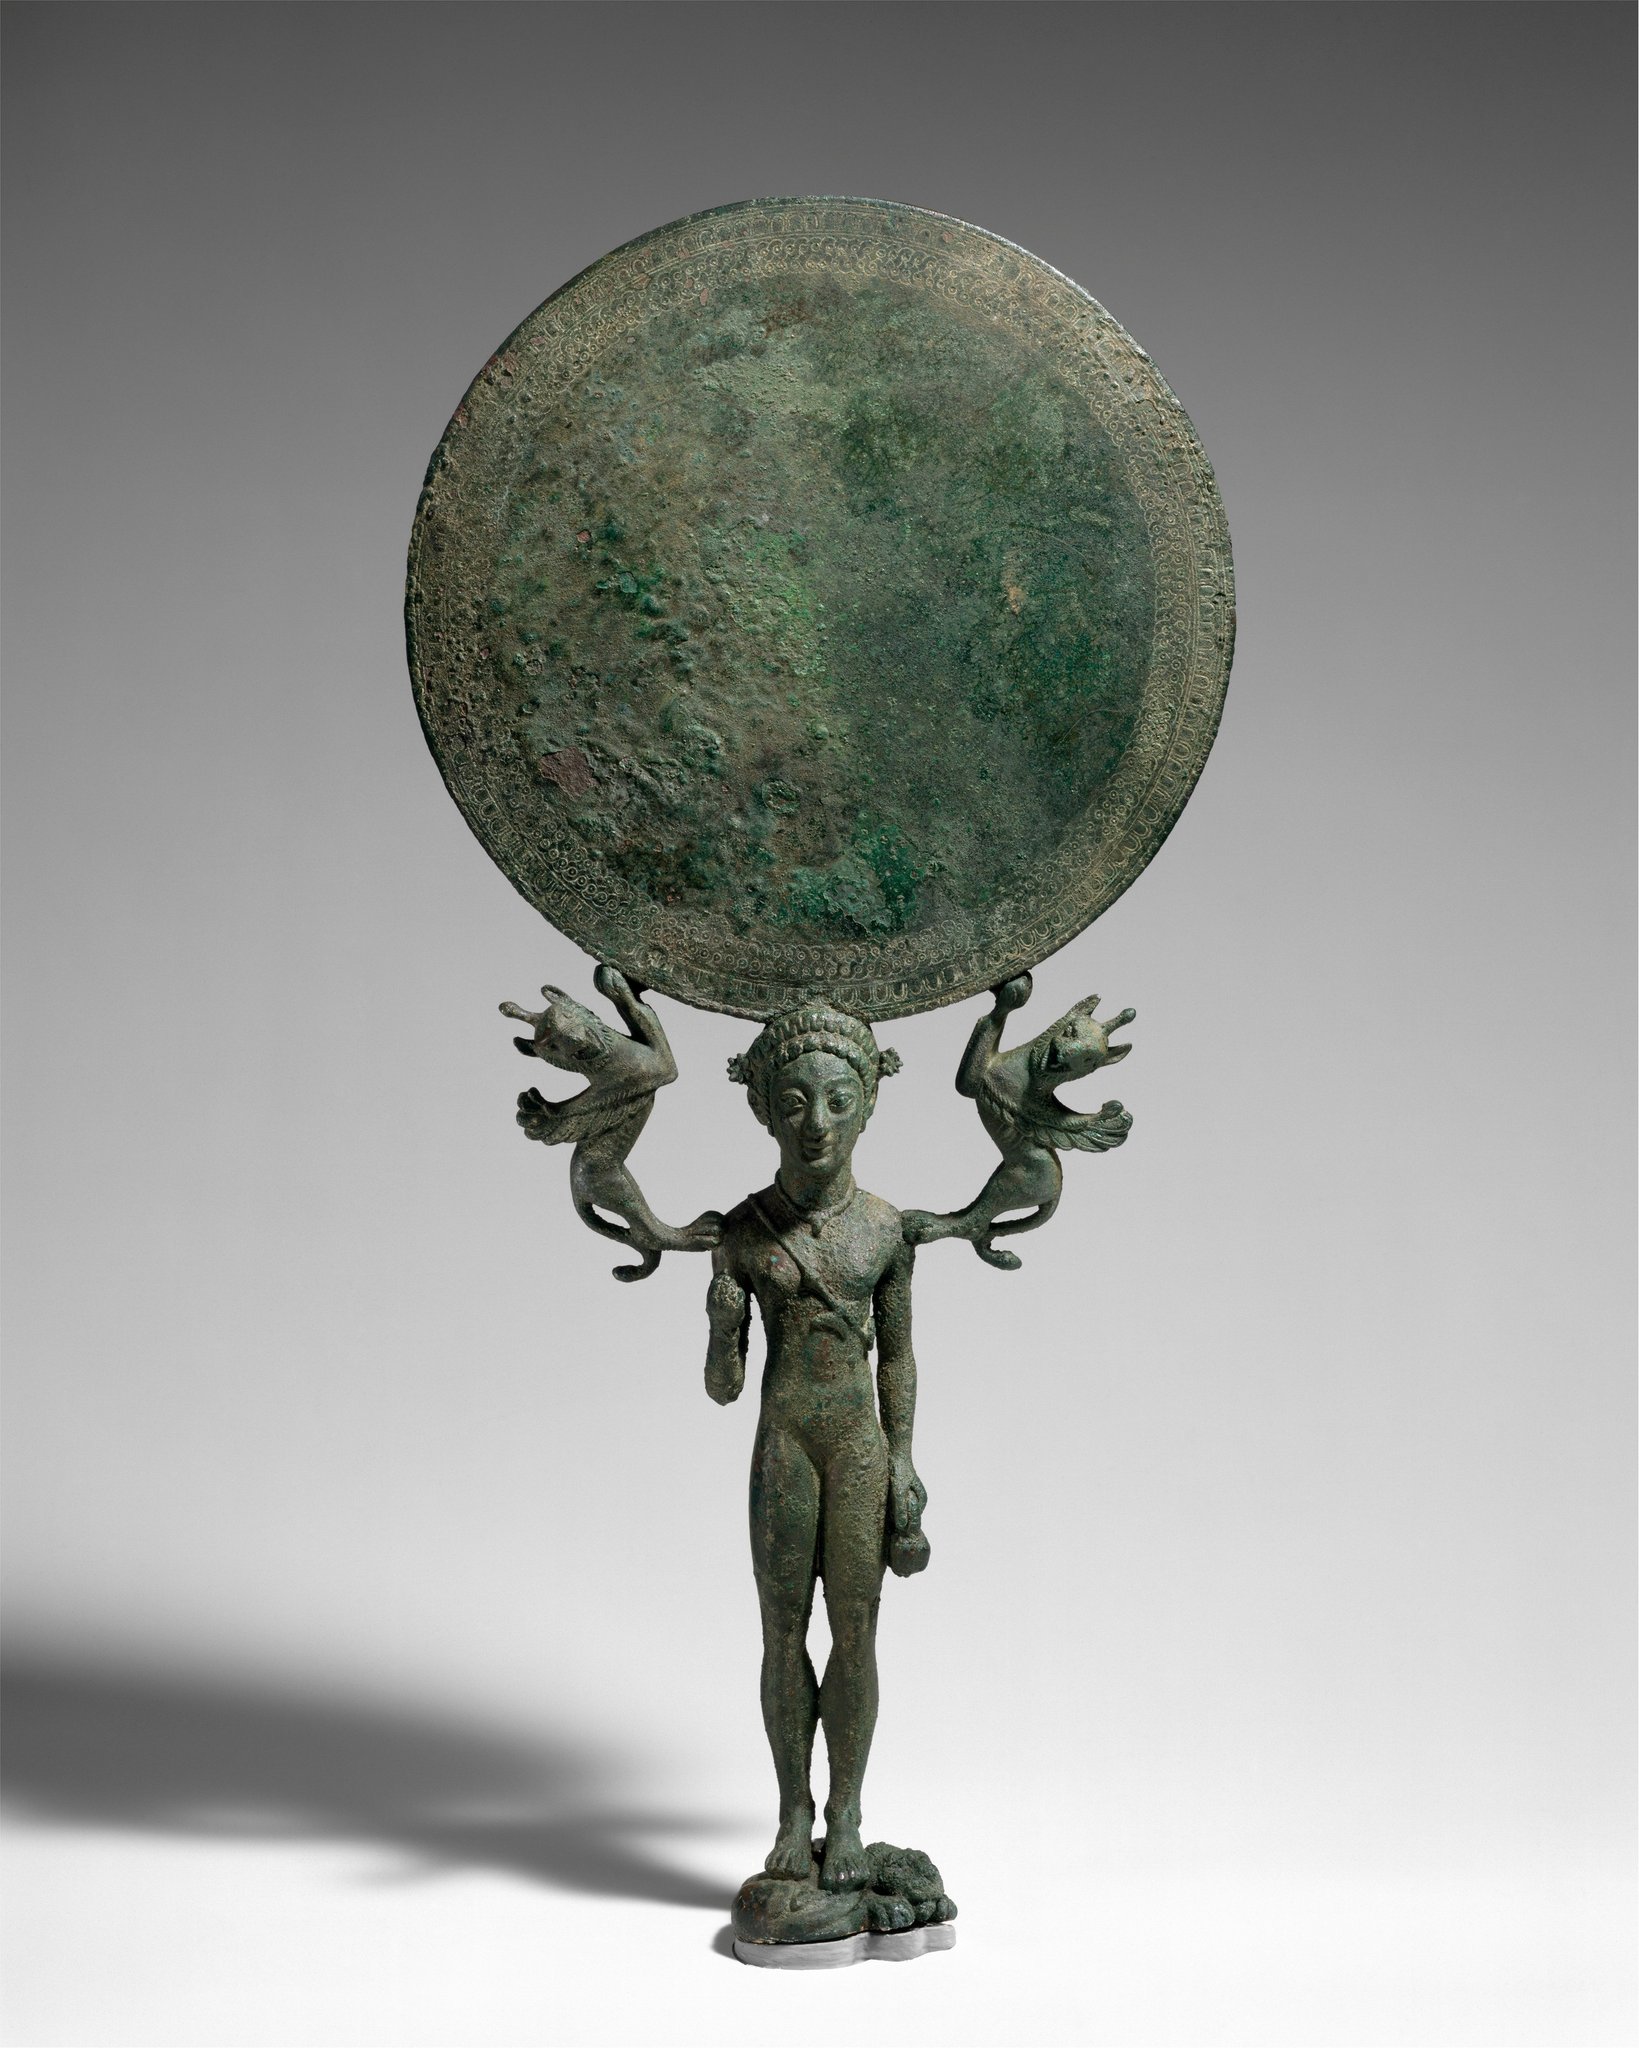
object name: mirror with support, girl with griffin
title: Bronze mirror with a support in the form of a nude girl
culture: greek, laconian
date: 550-501 BCE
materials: bronze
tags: female nudes,griffins